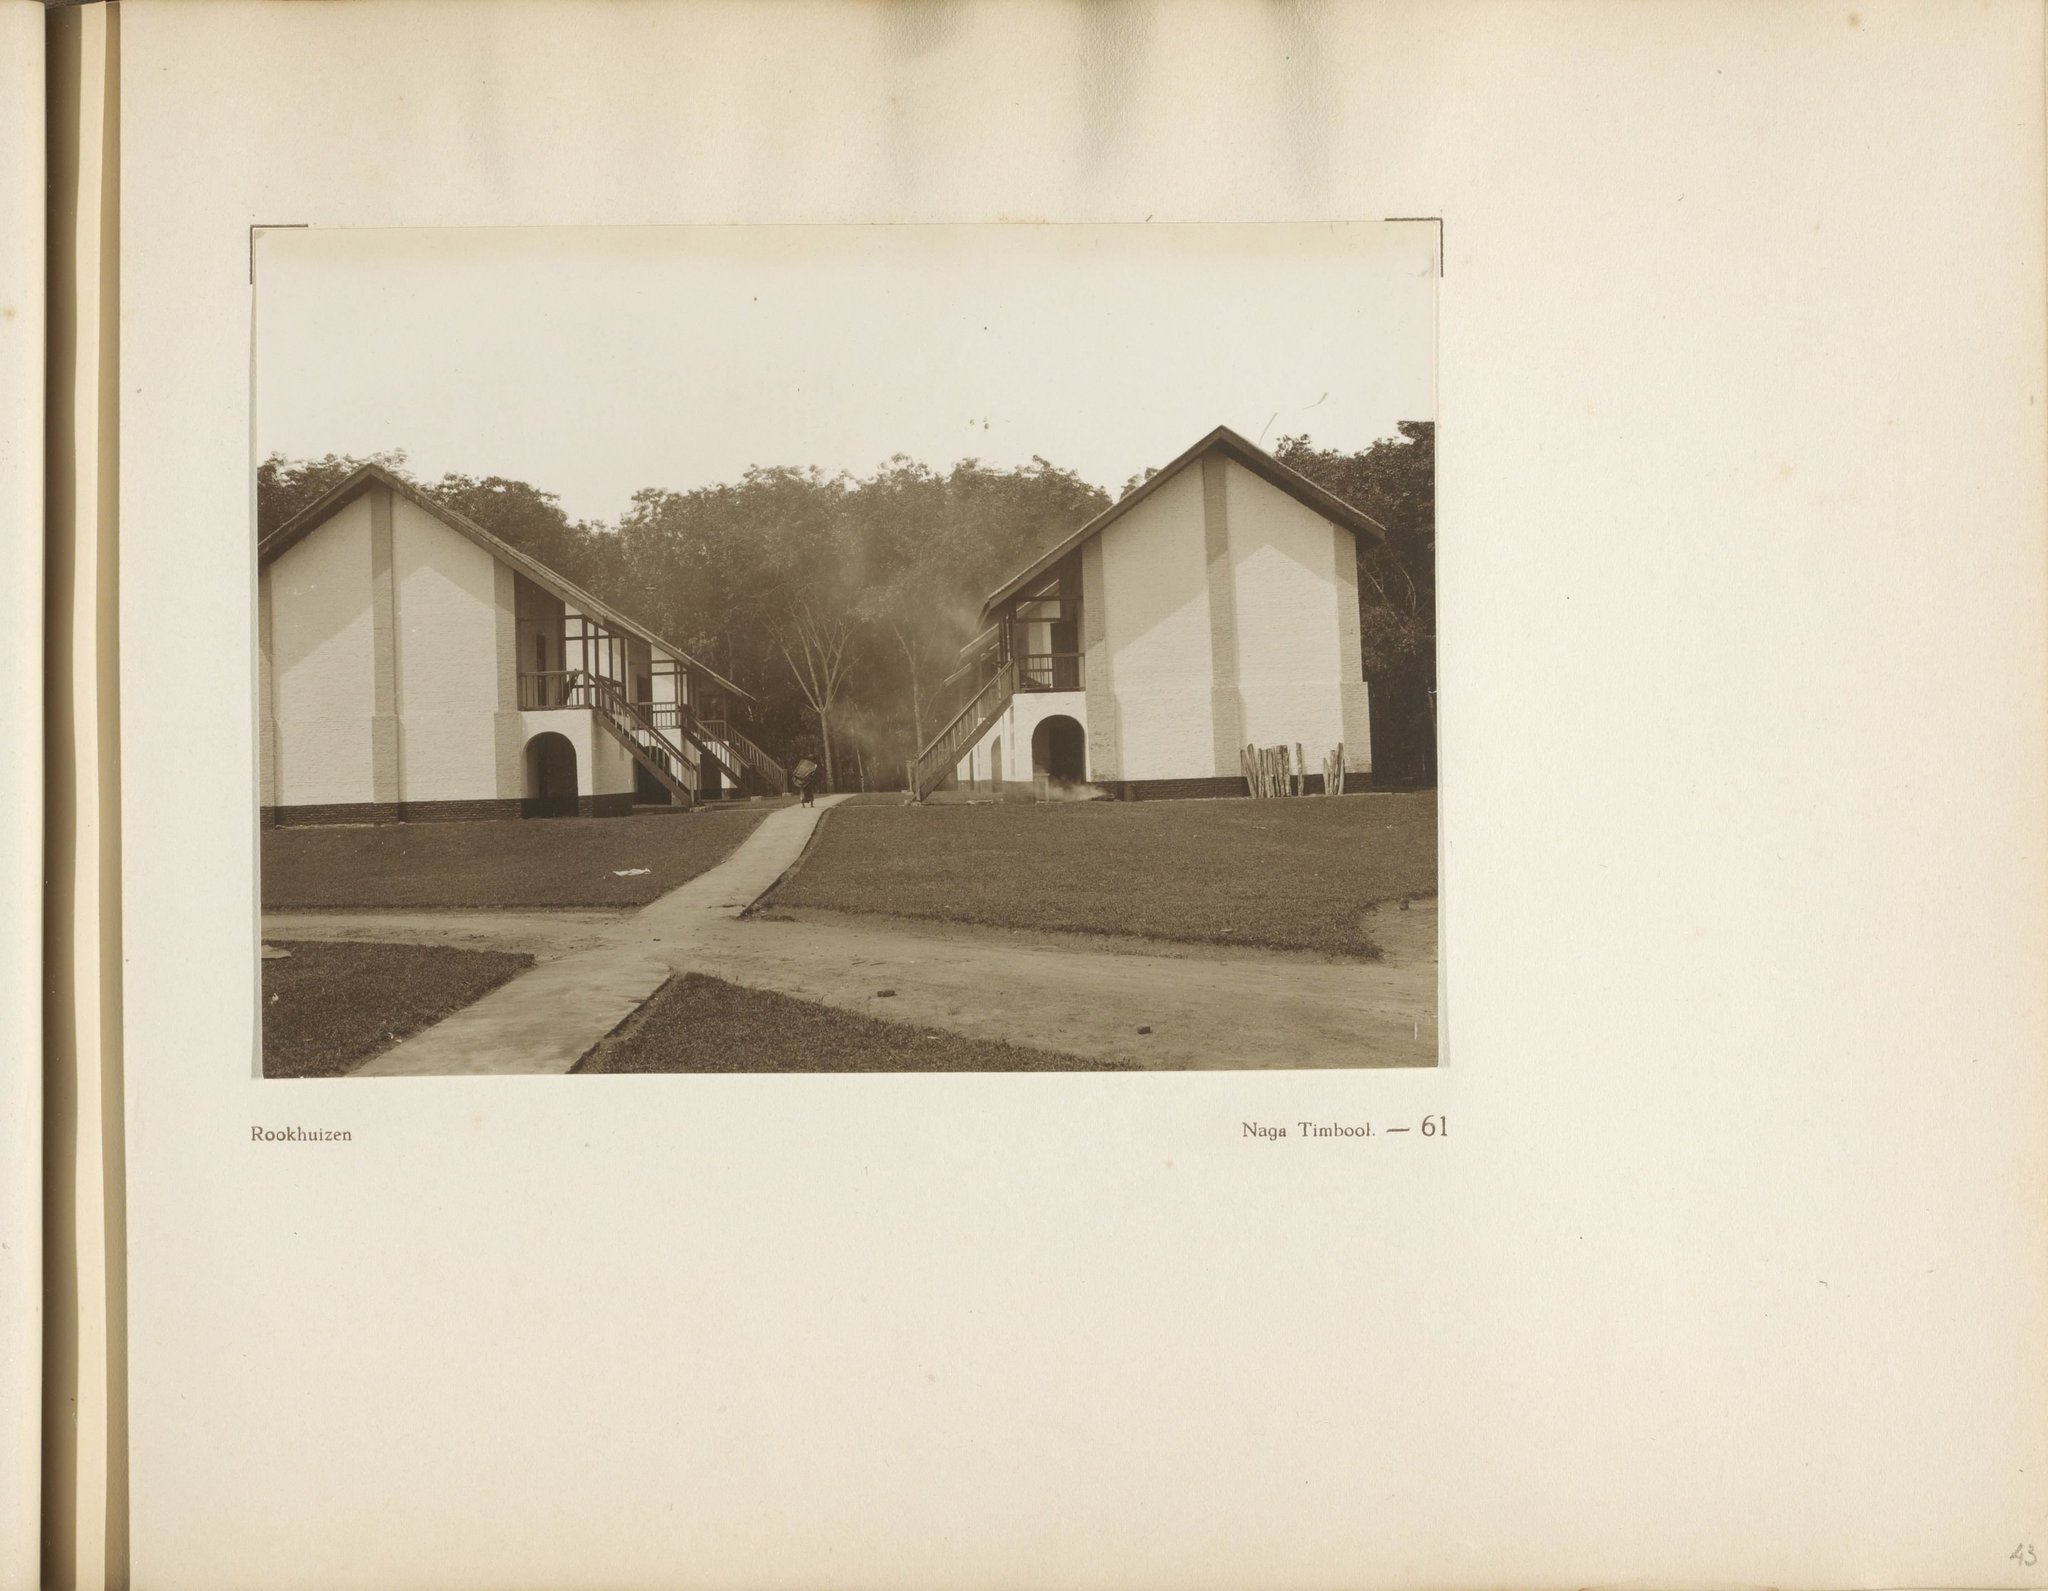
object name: photograph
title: Pagina 61 van fotoboek van de Algemeene Vereeniging van Rubberplanters ter Oostkust van Sumatra (A.V.R.O.S.)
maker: j.w. meyster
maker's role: fotograaf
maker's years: 1887-1945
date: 1924-1925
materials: paper, photographic support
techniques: printing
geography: sumatra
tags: factory-building, factory-interior, machine shop, (non-fruit) products of plants or trees: rubber, sumatra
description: Boekpagina met een foto van het exterieur van rookhuizen van een rubberfabriek van de Algemeene Vereeniging van Rubberplanters ter Oostkust van Sumatra (A.V.R.O.S.) te Naga Timbool. Onderdeel van een fotoboek van de Algemeene Vereeniging van Rubberplanters ter Oostkust van Sumatra (A.V.R.O.S.).